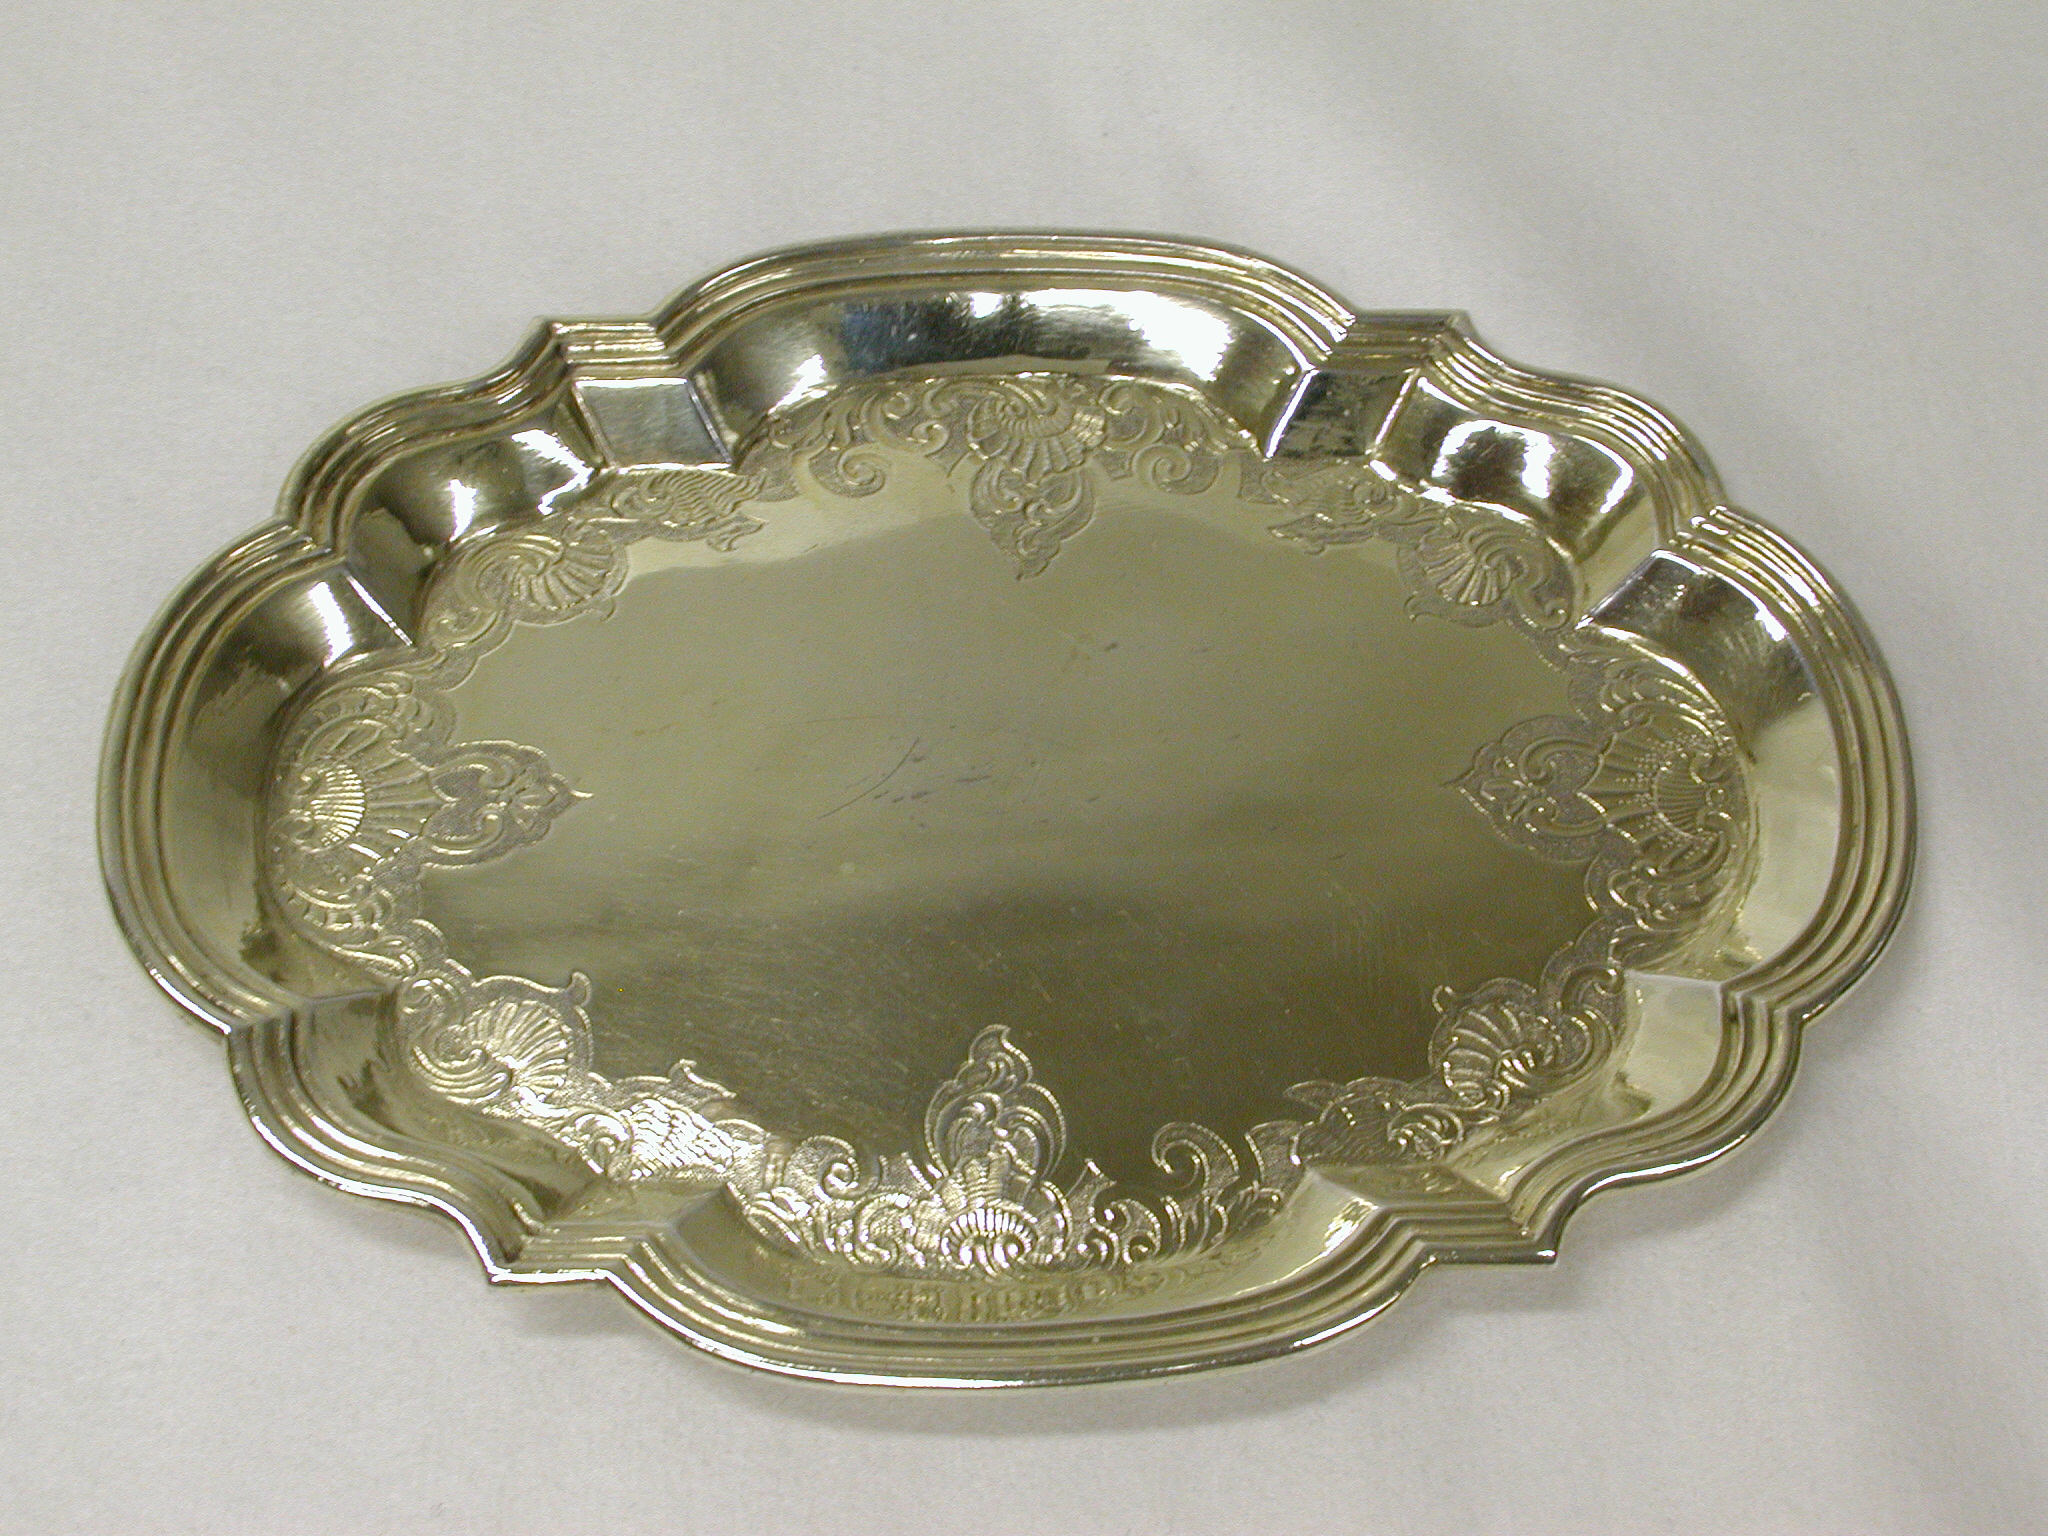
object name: tray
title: Tray (one of a pair)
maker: johann conrad lotter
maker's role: maker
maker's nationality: german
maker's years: 1738-1779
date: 1743-1745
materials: silver gilt